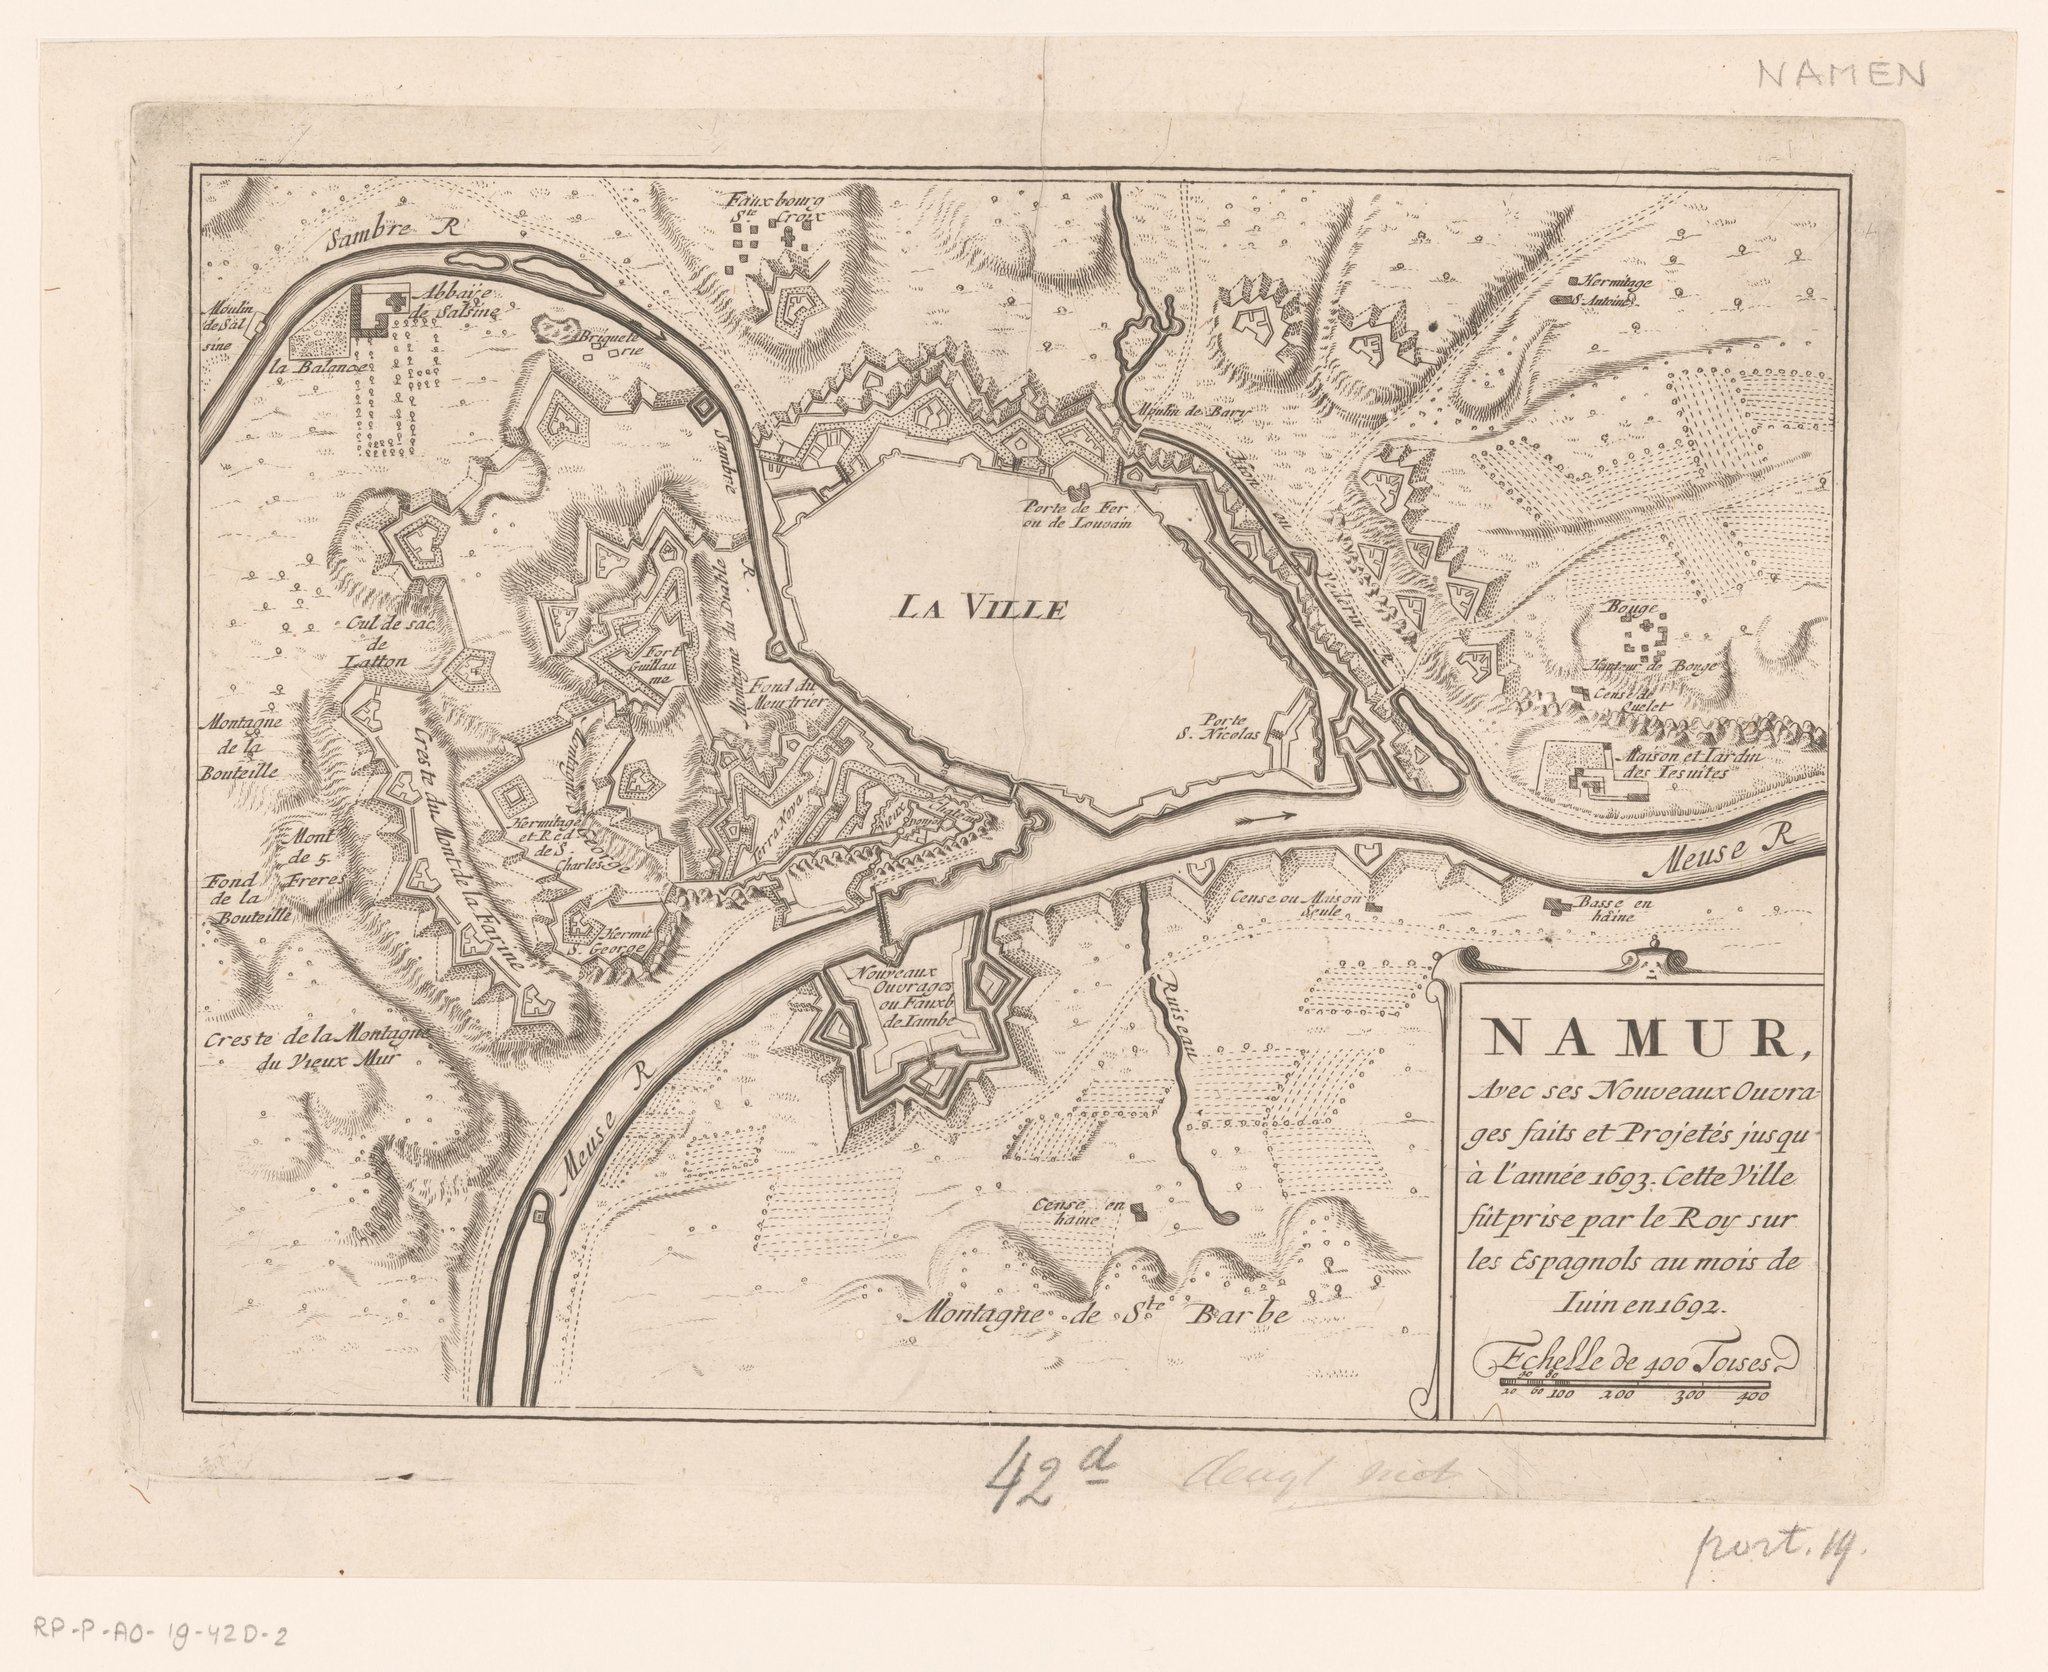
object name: area plan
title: Namur, avec ses nouveaux ouvrages faits et projetés jusqu á l'année (...)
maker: Anonymous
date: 1690-1700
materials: paper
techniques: engraving, etching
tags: fortified city, maps of cities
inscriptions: collector's mark: Lugt 2228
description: Prent ook gebruikt in: Fer, Nicolas de. Les forces de l'Europe, ou description des principales villes, avec leurs fortifications : dessignées par les meilleurs ingenieurs, particulierement celles (…). Parijs: Nicolas de Fer, 1690-1695. En in: Las Fuerzas de la Europa, o la descripcion de las principales ciudades (…). Amsterdam: George Gallet, 1700. En in: Les forces de l'Europe. Amsterdam: Pieter Mortier (I), [ca. 1700].